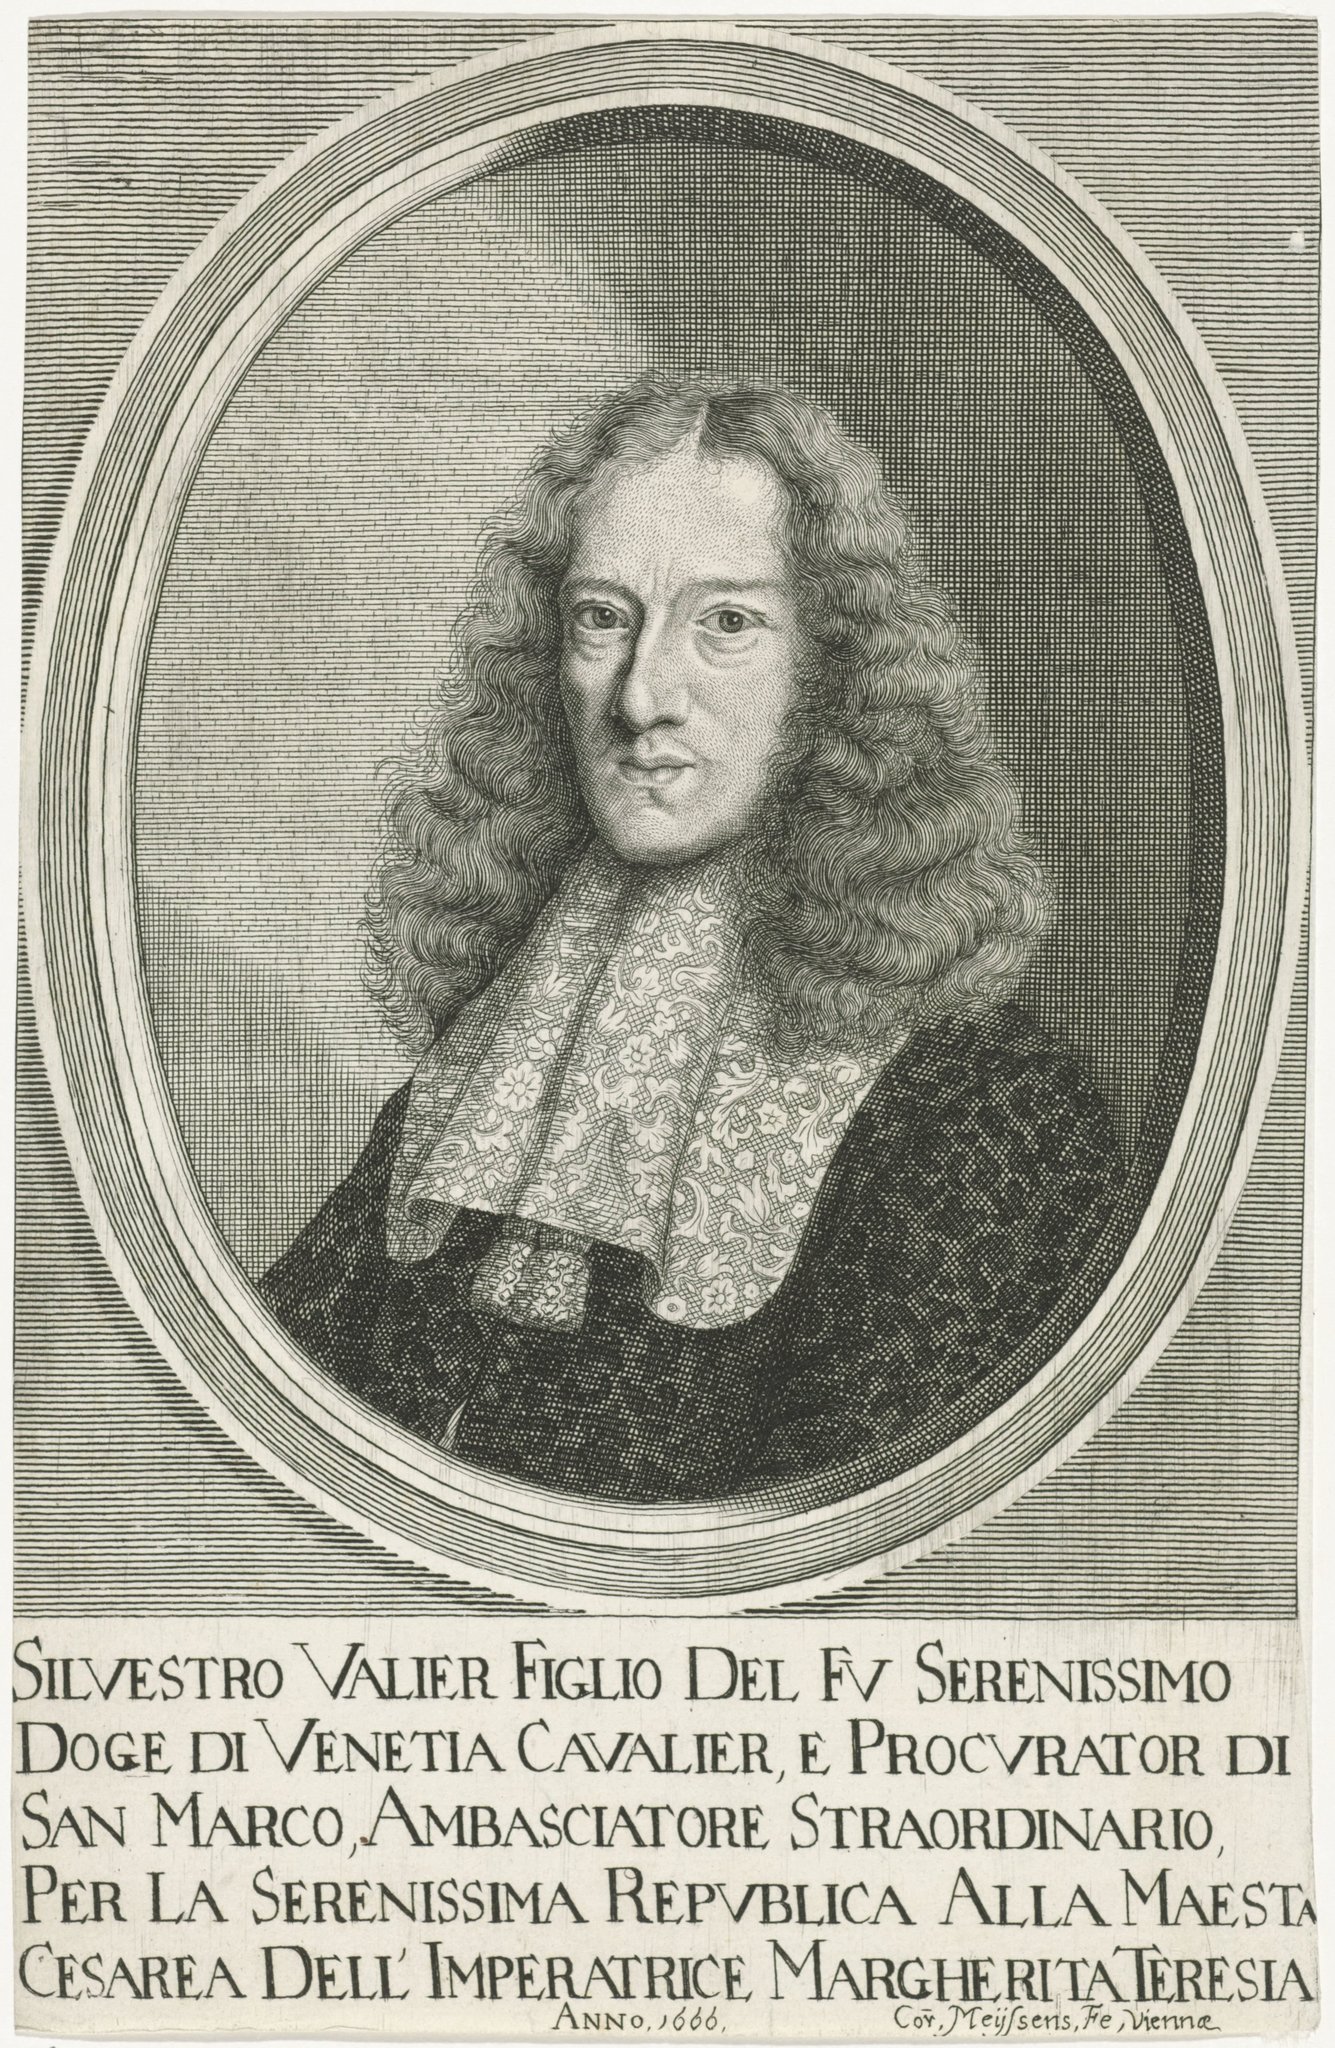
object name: print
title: Portret van Silvestro Valiero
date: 1670-1674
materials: paper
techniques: engraving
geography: vienna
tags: venice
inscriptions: collector's mark: Lugt 2228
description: Prent mogelijk gebruikt in: Gualdo Priorato, Galeazzo. Historia di Leopoldo Cesare, (...). 3 dln. Wenen, Giovanni Battista Hacque, 1670-1674.